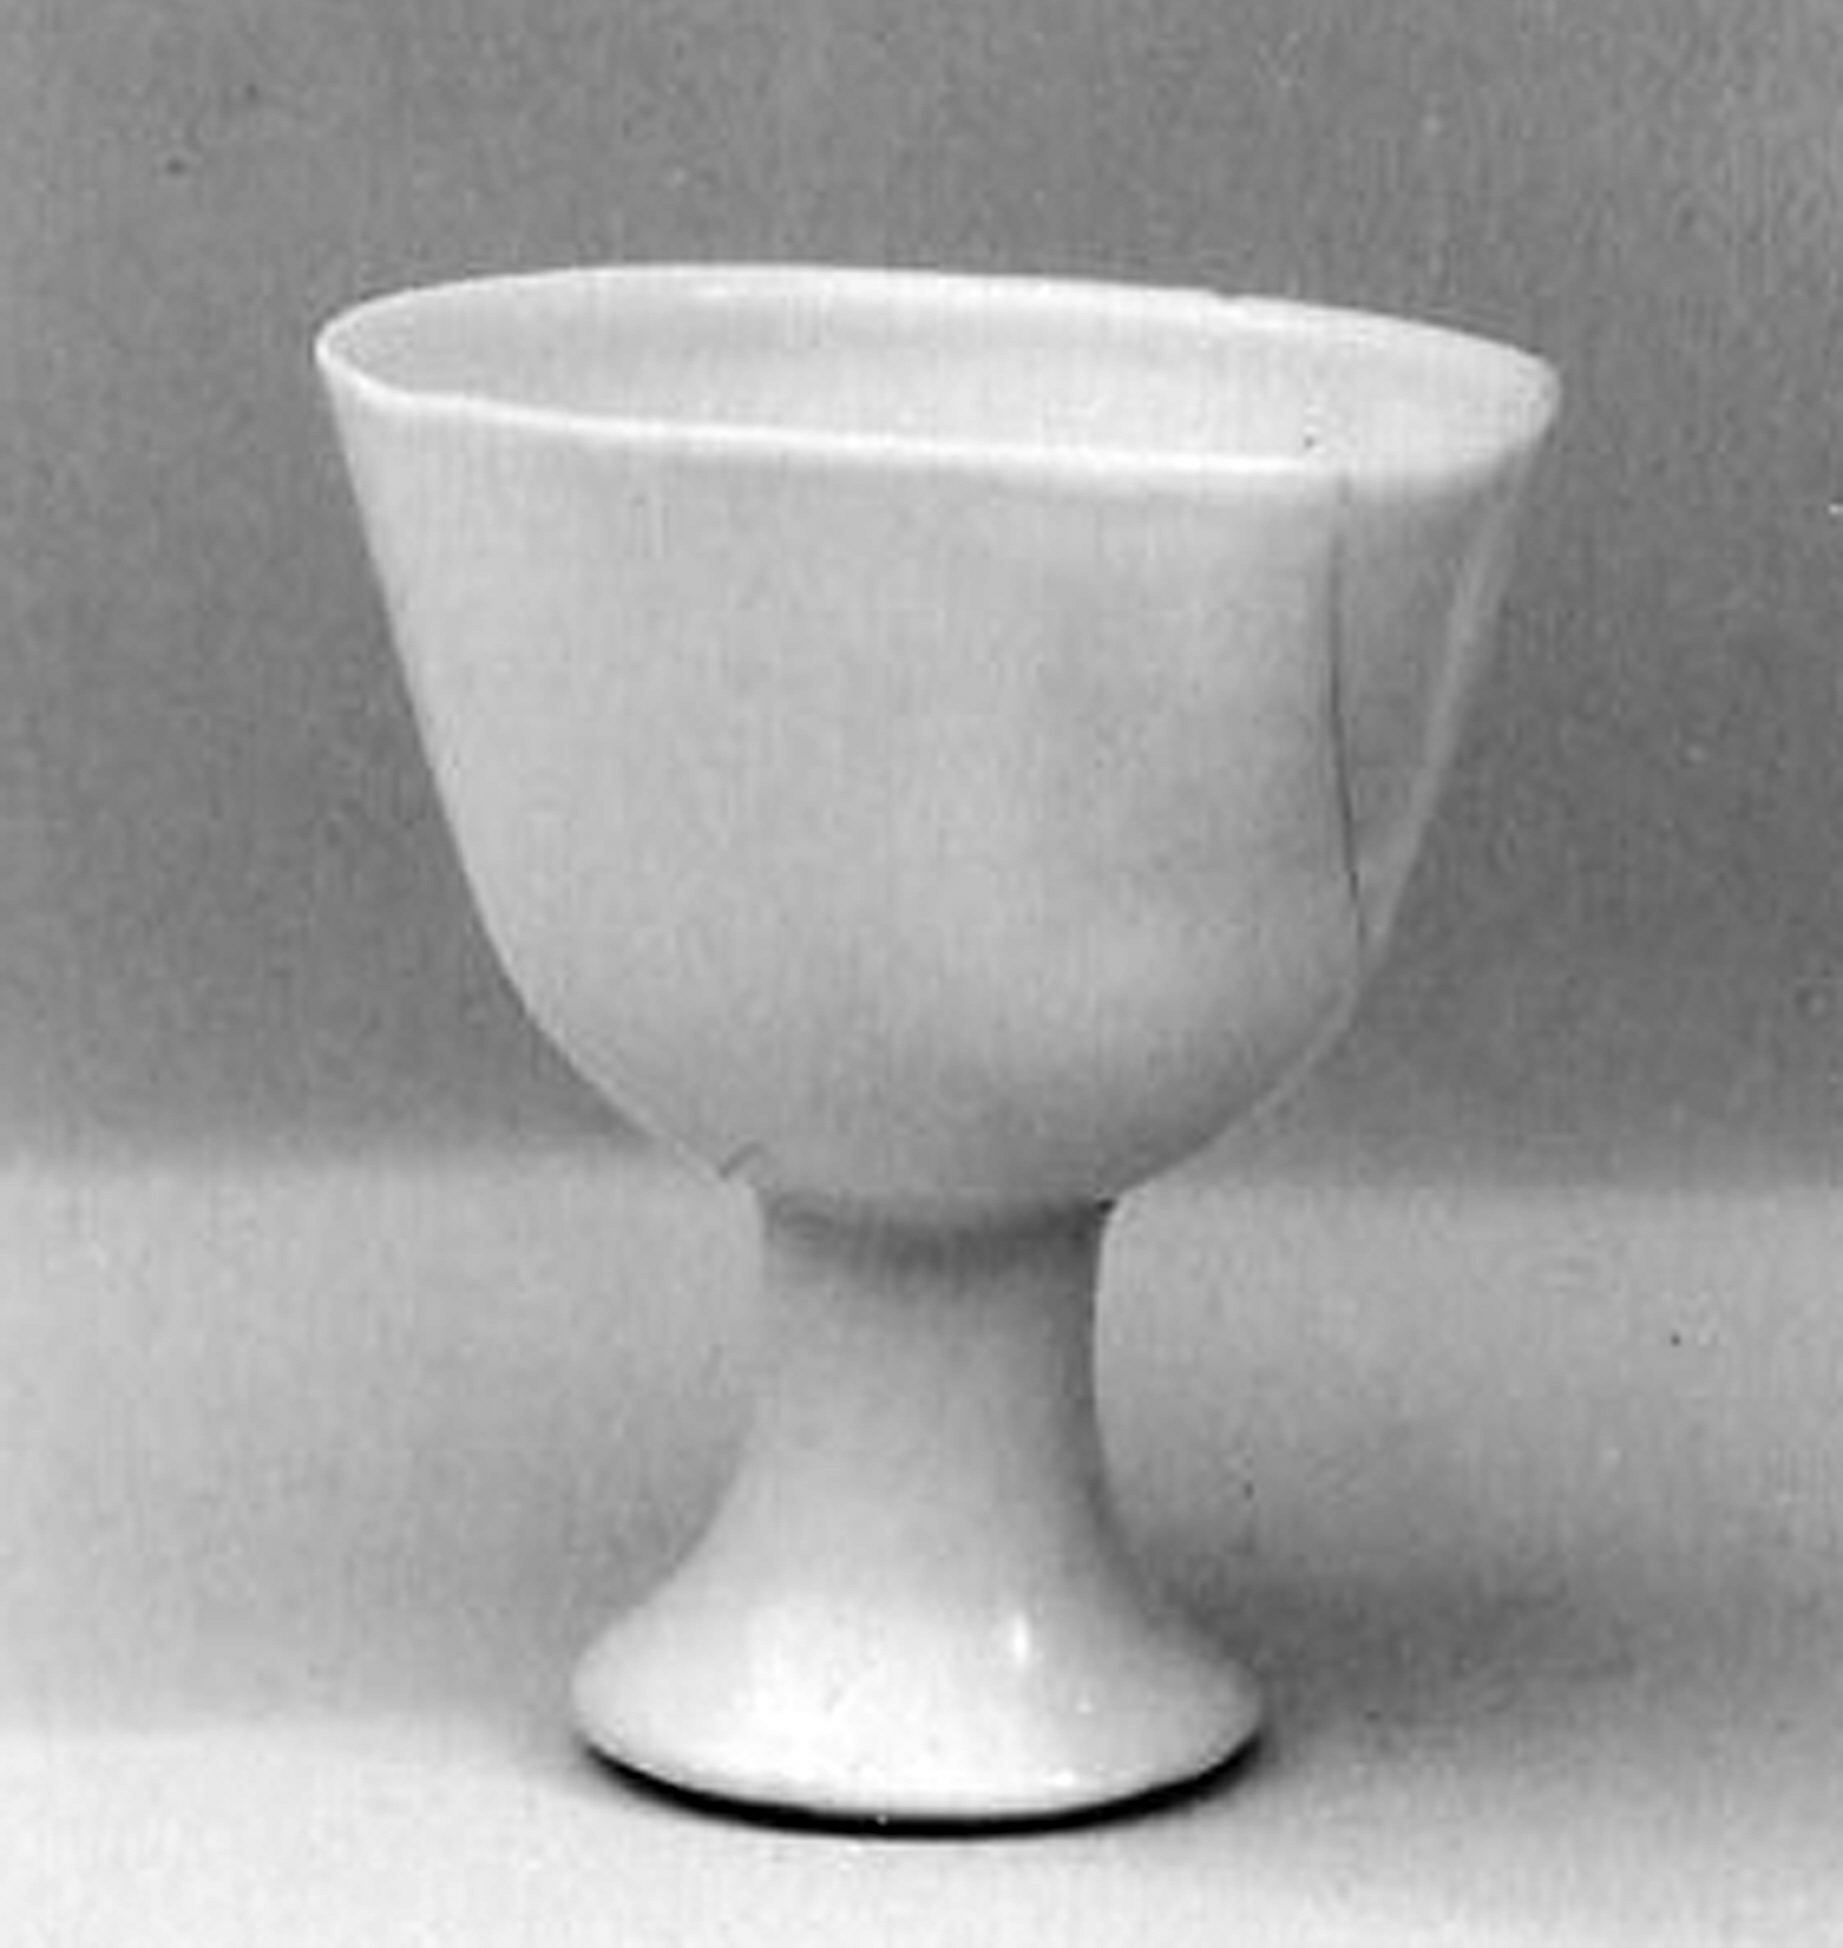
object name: stem cup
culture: chinese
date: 1401-1500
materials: glaze, porcelain